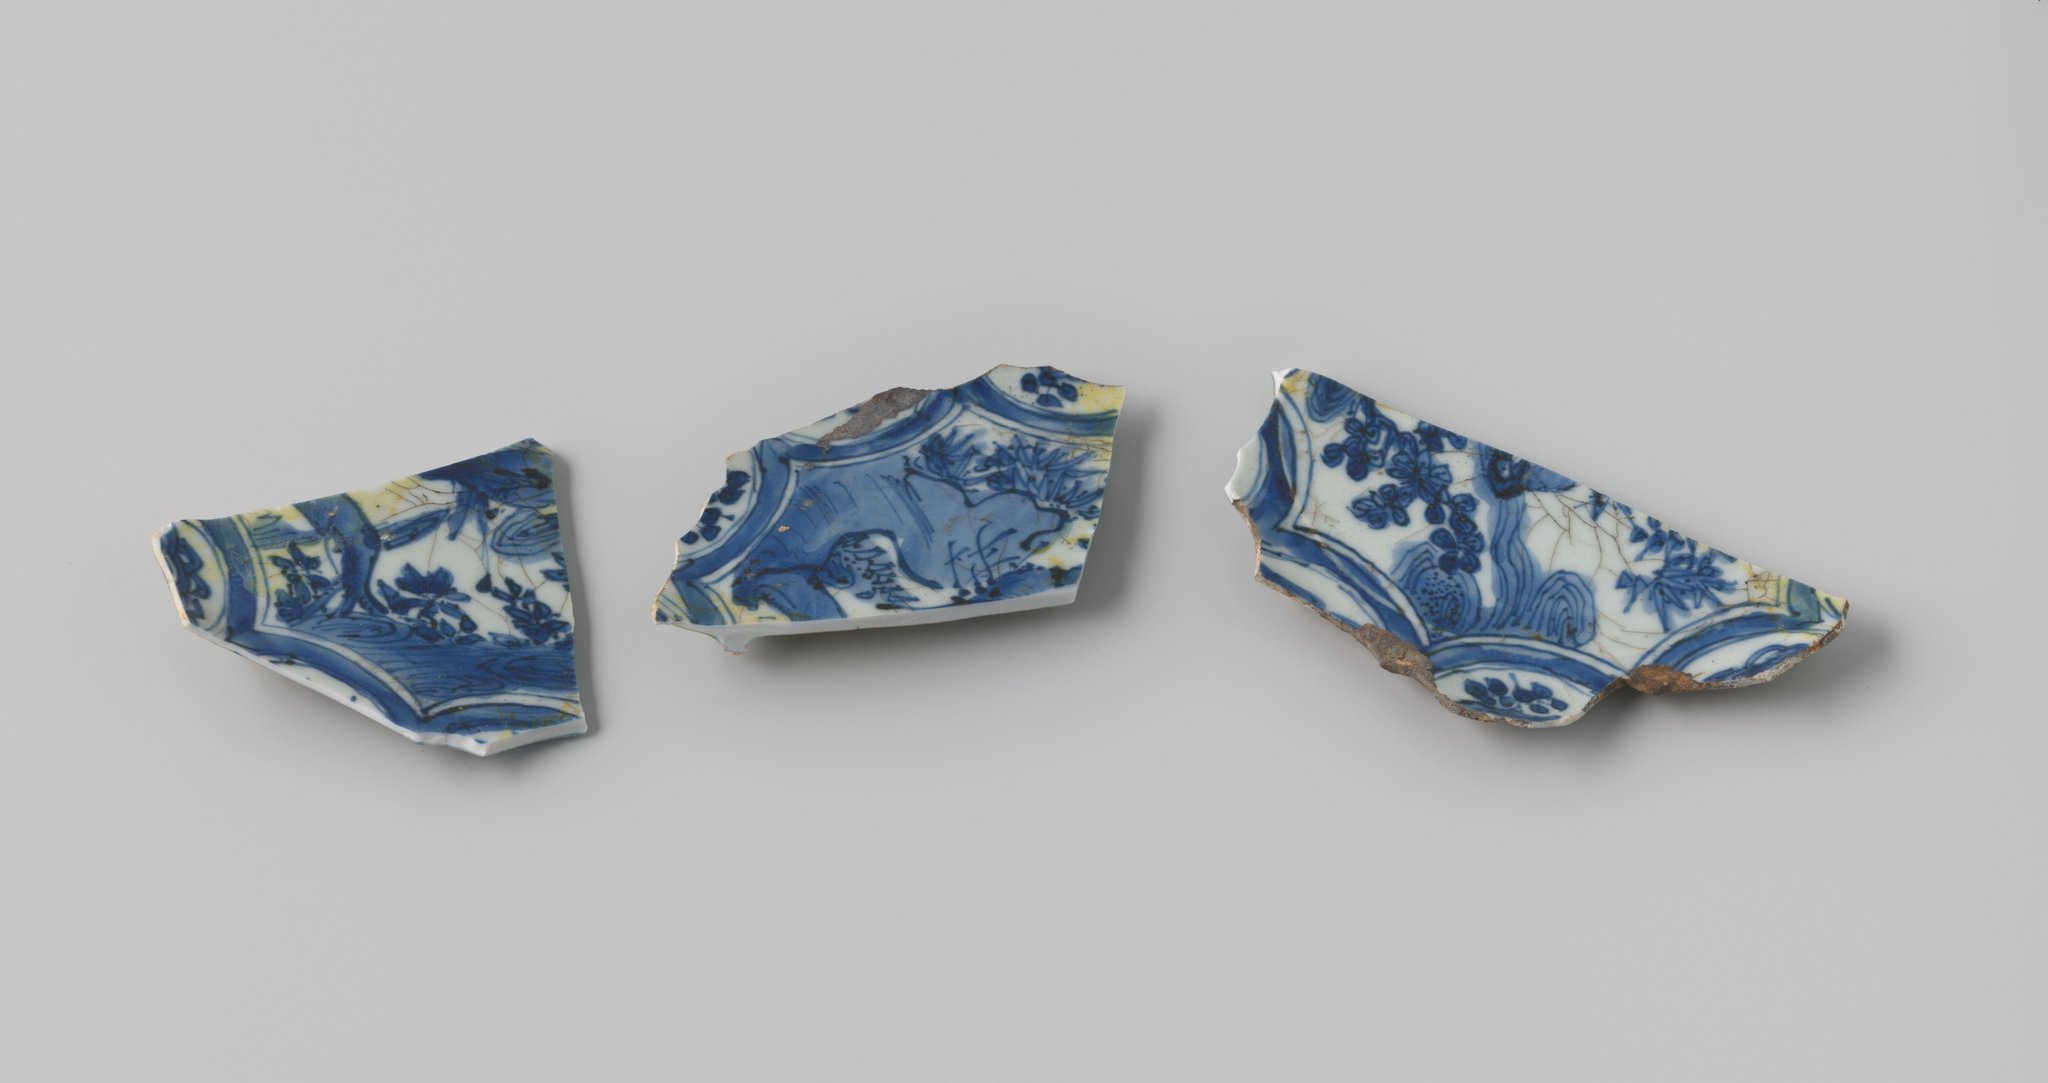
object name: plate dish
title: Scherven van een bord uit V.O.C.-schip de 'Witte Leeuw'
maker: Anonymous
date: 1613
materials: bone china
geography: jingdezhen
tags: verenigde oostindische compagnie, sint-helena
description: A dish without a flattened rim. An eight-sided thickly drawn medallion. A central decoration of a bird on a rock next to a peony in a marsh landscape. The medallions decorated with alternately a peach, flower and a symbol.